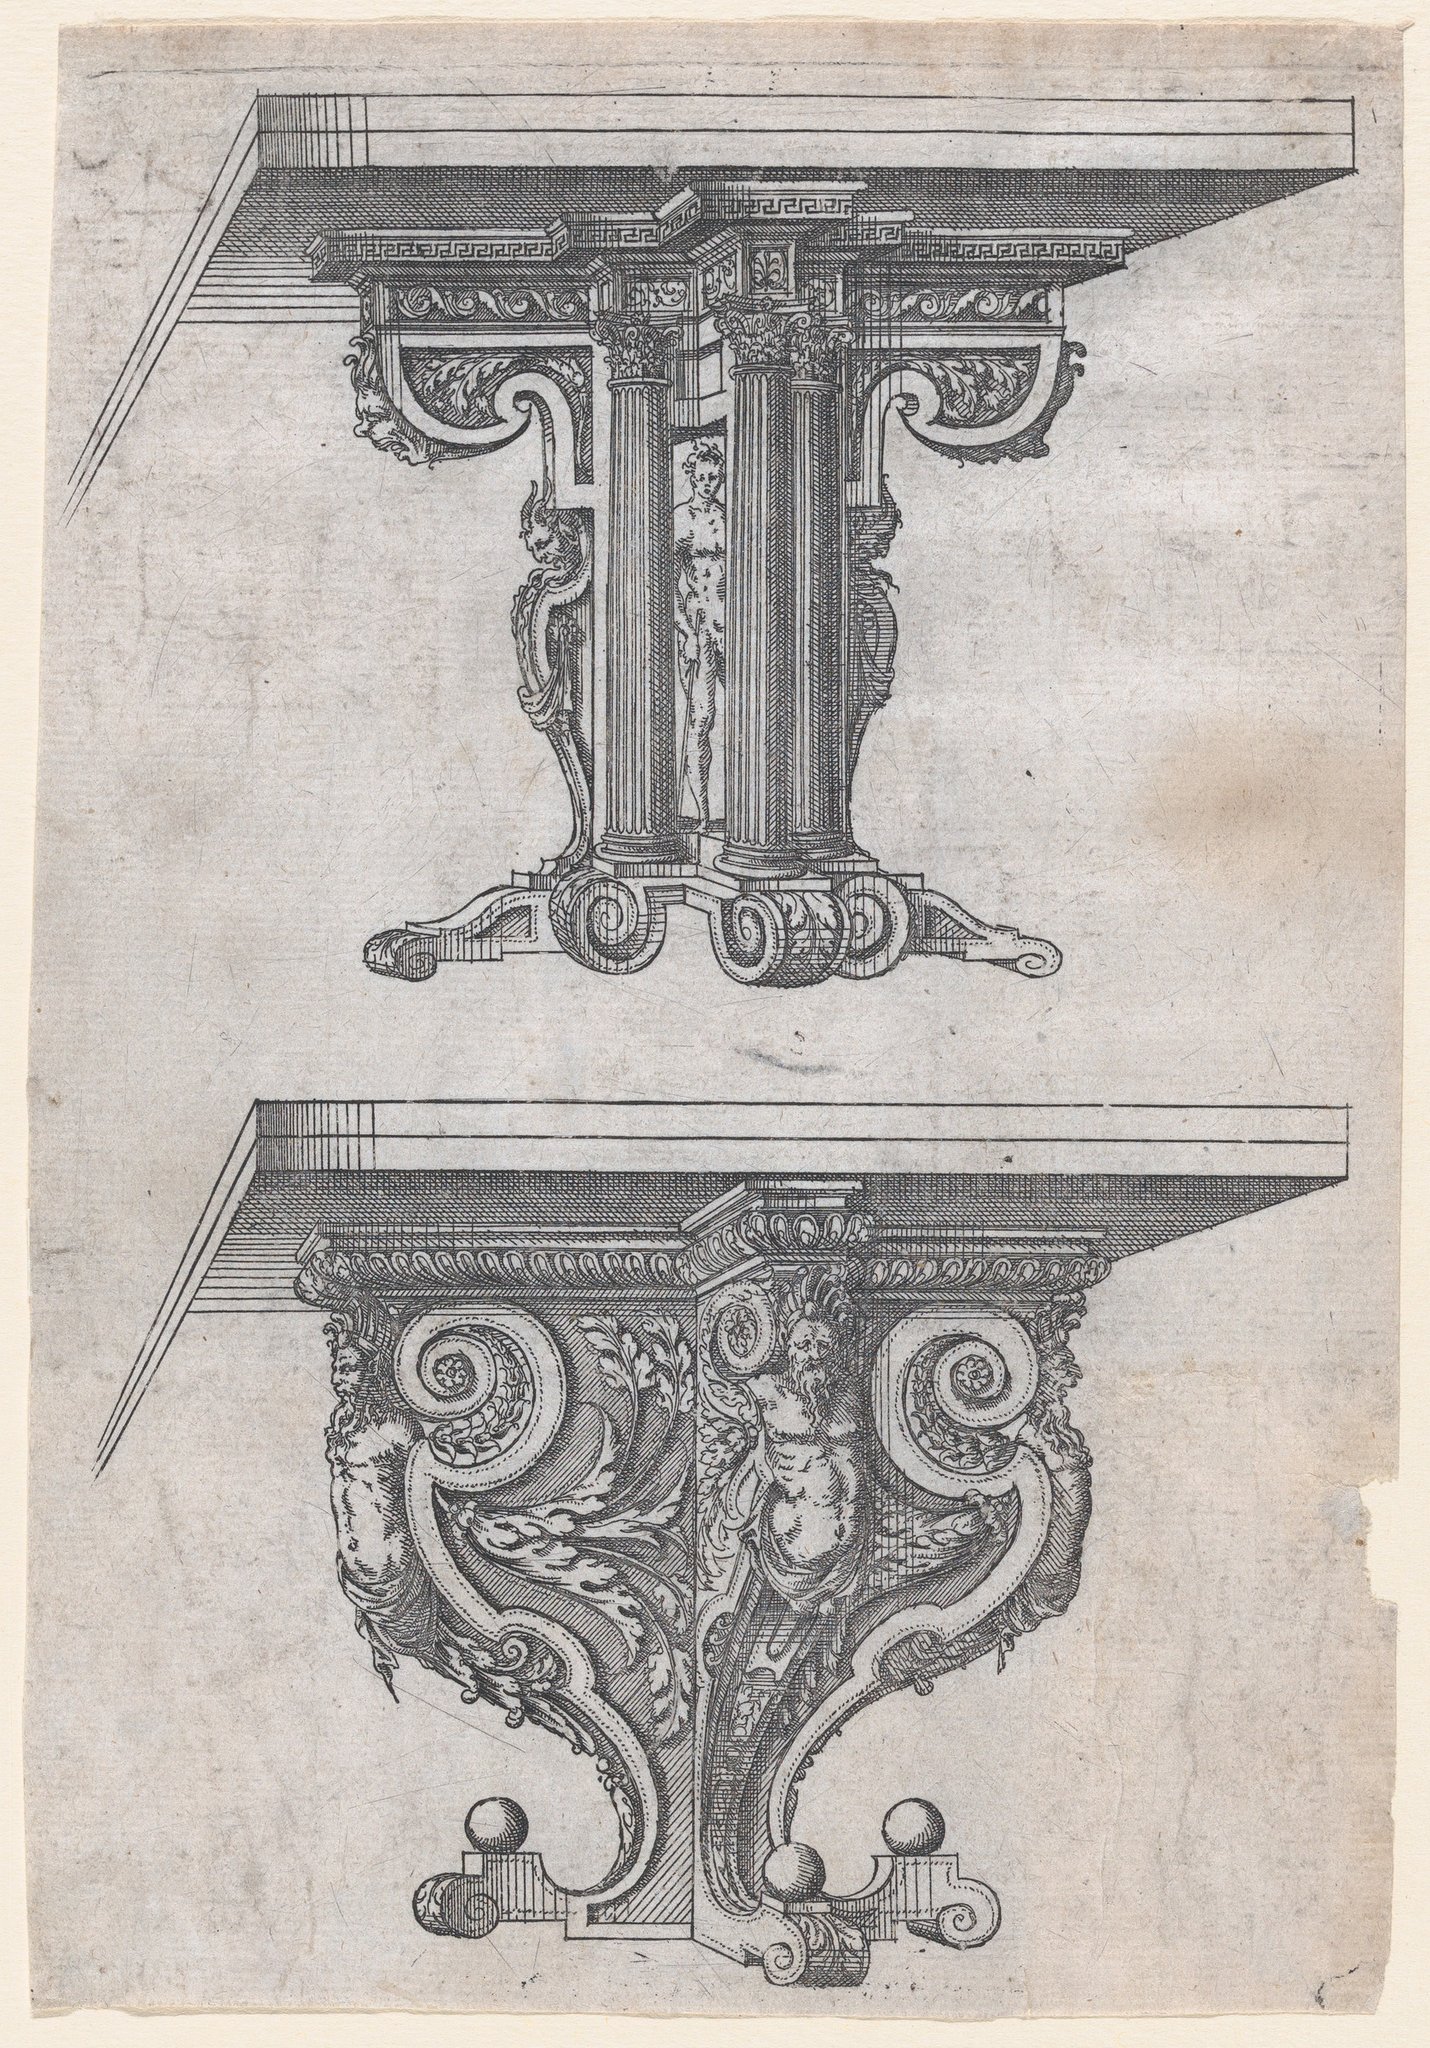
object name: print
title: Two Table Designs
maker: jacques androuet du cerceau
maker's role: artist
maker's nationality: french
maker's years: 1510-1585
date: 1565-1570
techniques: etching